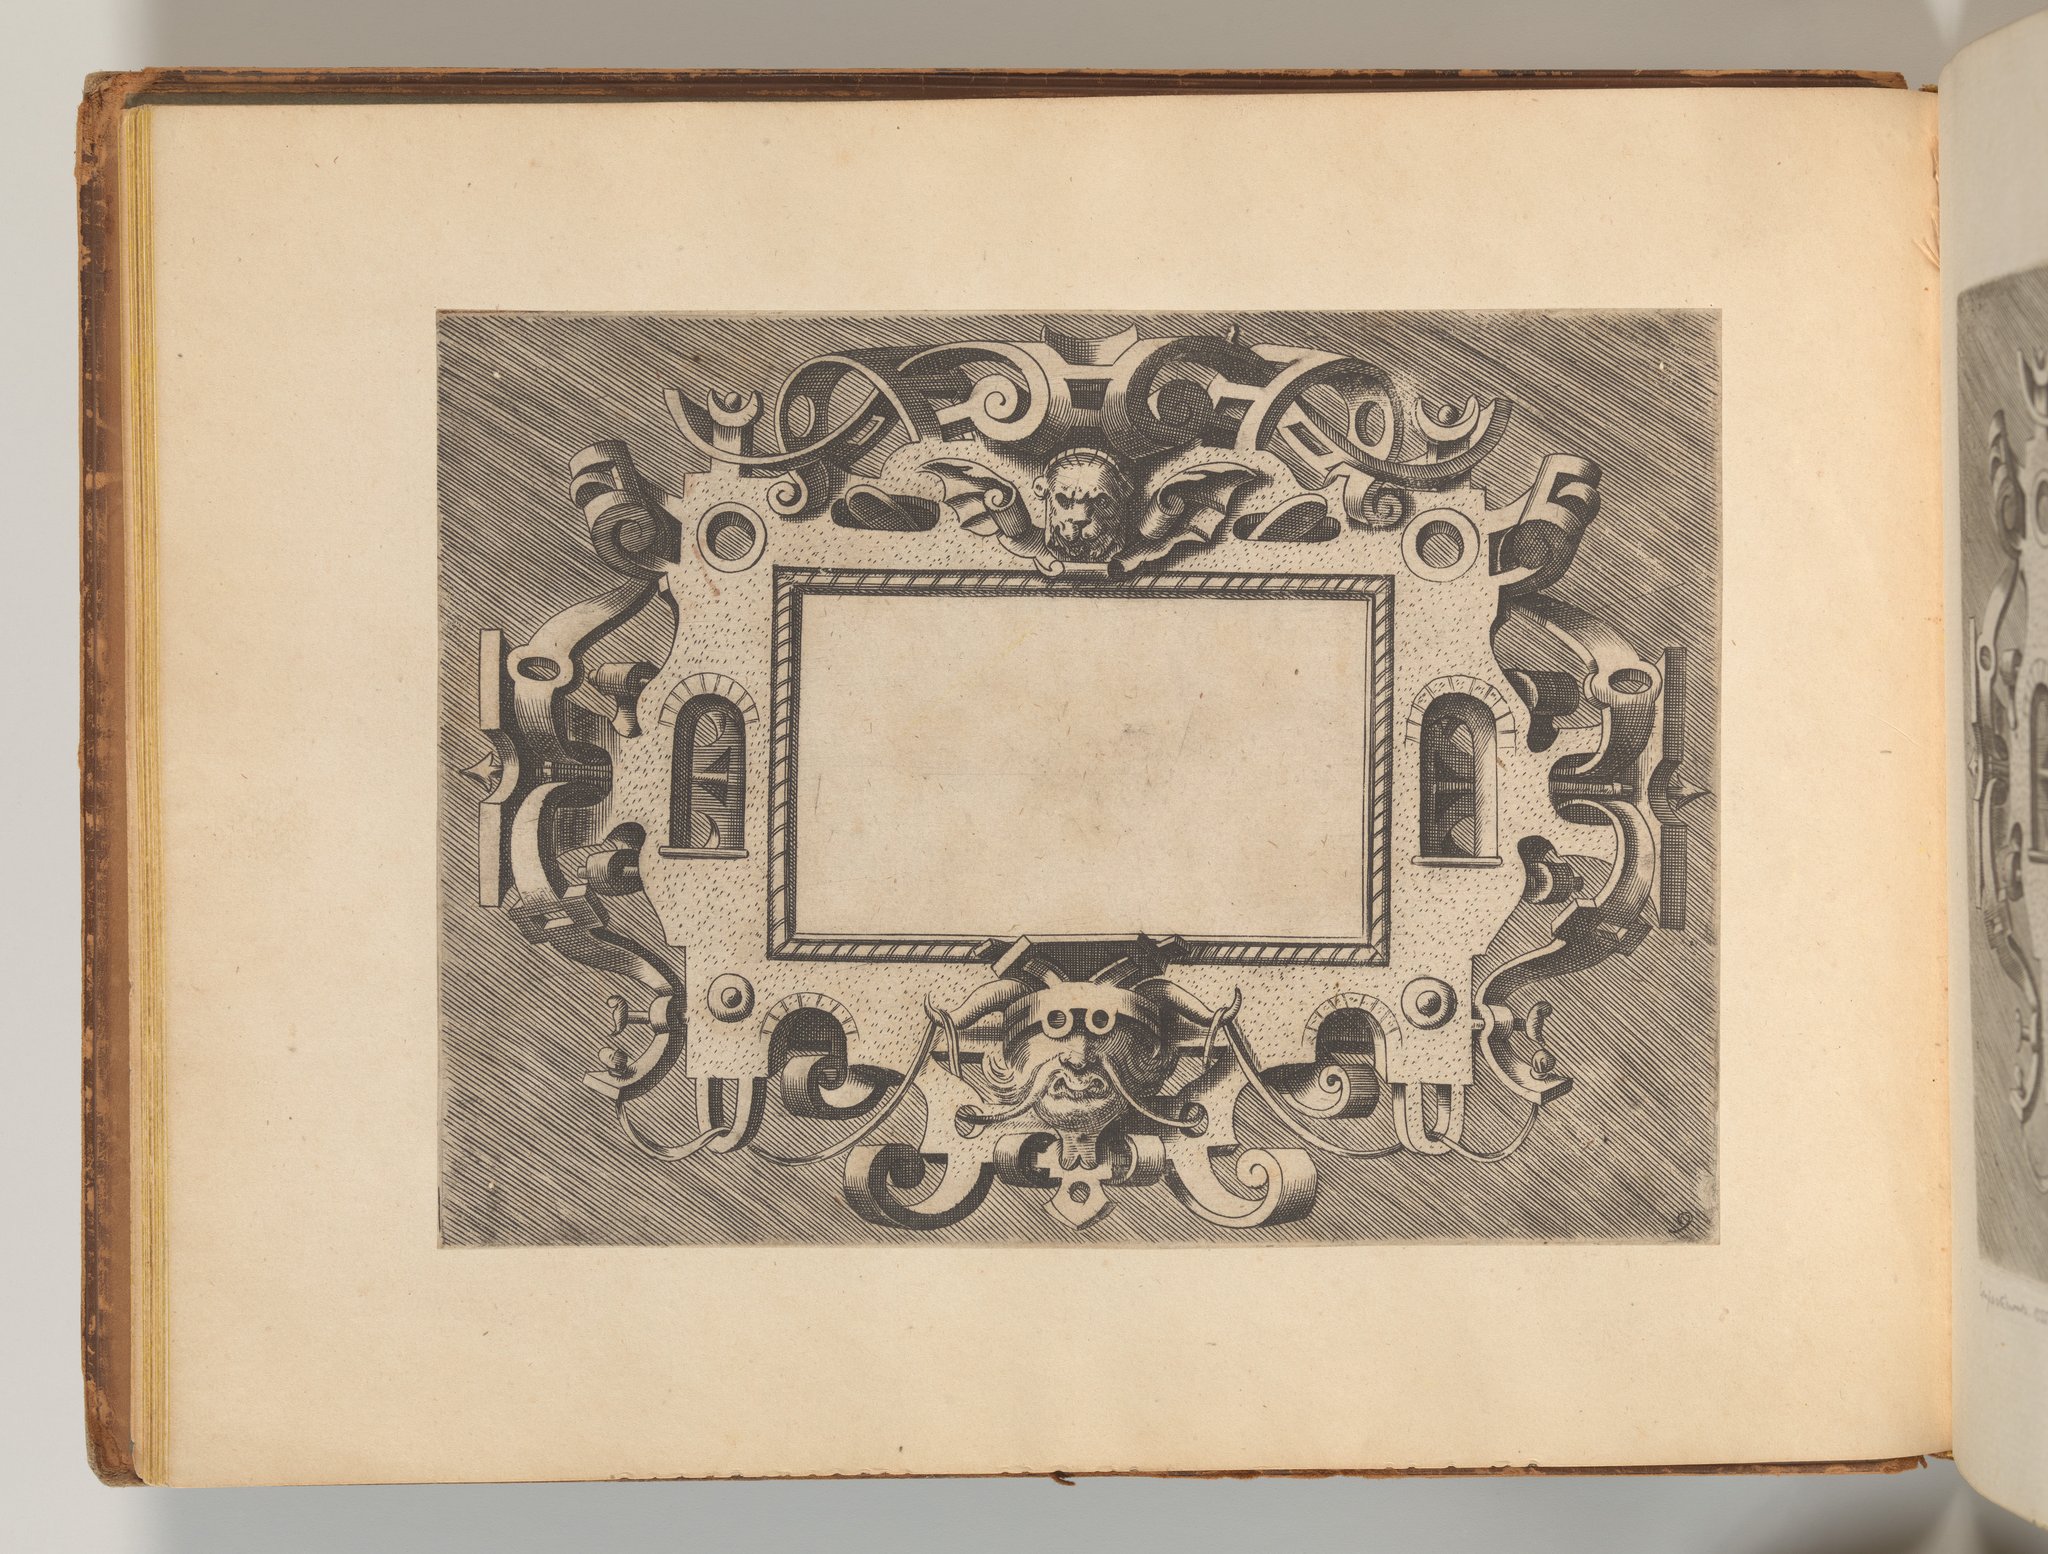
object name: album print ornament architecture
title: Targhe ed altri ornati di varie e capricciose invenzioni (Cartouches and other ornaments of various and capricious invention, page 15)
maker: hans vredeman de vries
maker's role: artist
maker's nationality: netherlandish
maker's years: 1527-1606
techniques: engraving, etching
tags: cartouches,ornament